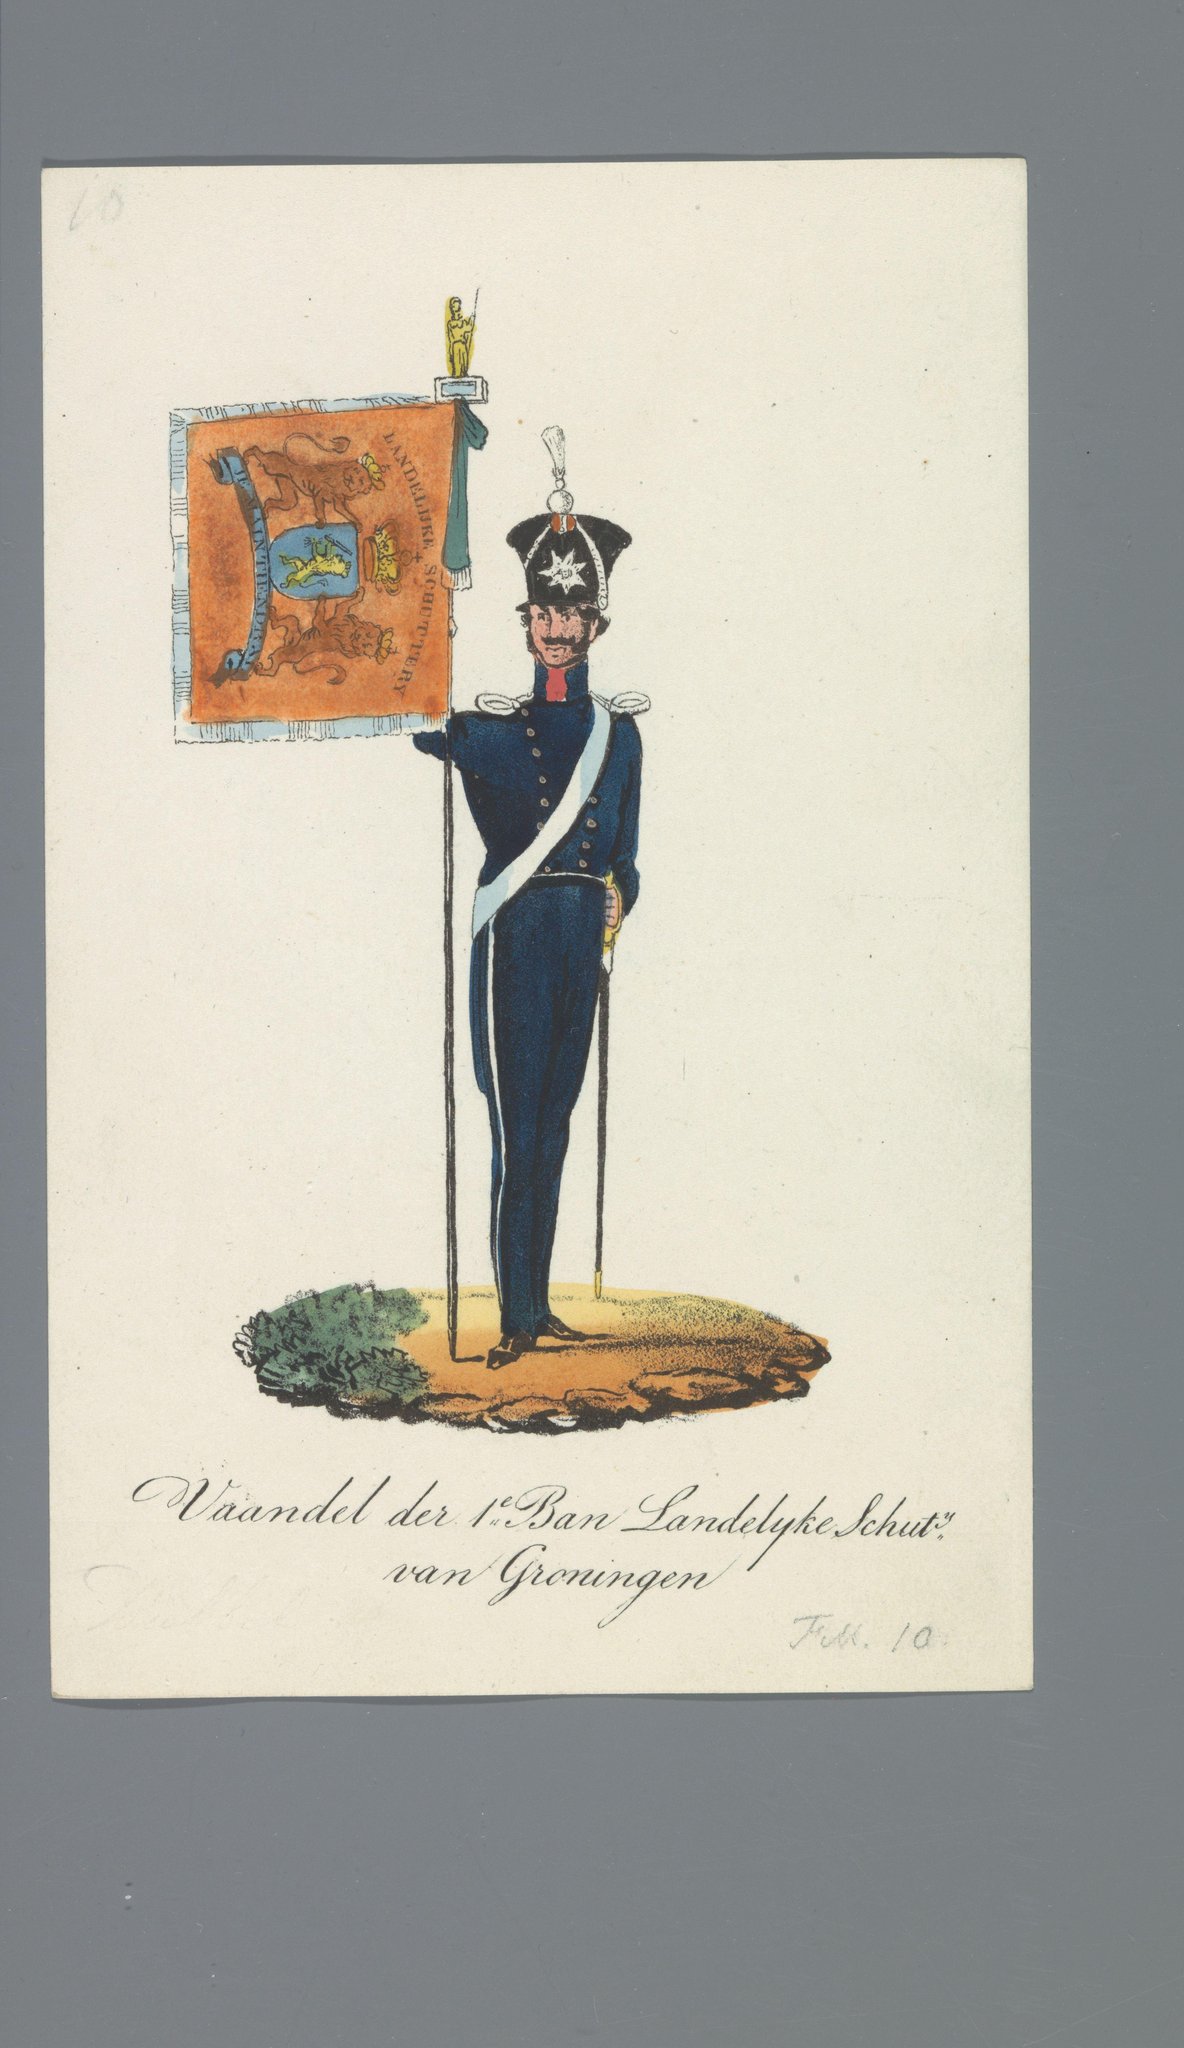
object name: costume print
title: Vaandel der 1e Ban Landelijke Schut.ij van Groningen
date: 1835-1850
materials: paper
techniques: hand coloring, lithograph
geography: utrecht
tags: standard-bearer, flag-bearer, (military) uniforms, clothes, costume, groningen (province)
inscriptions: collector's mark: Lugt 2227, collector's mark: Lugt 2228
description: Staande schutter, vaandeldrager met het vaandel van het 1e Bataljon Landelijke Schutterij van Groningen. Onderdeel van een serie van 157 losse bladen met Nederlandse militaire uniformen in de jaren 1830-1832.